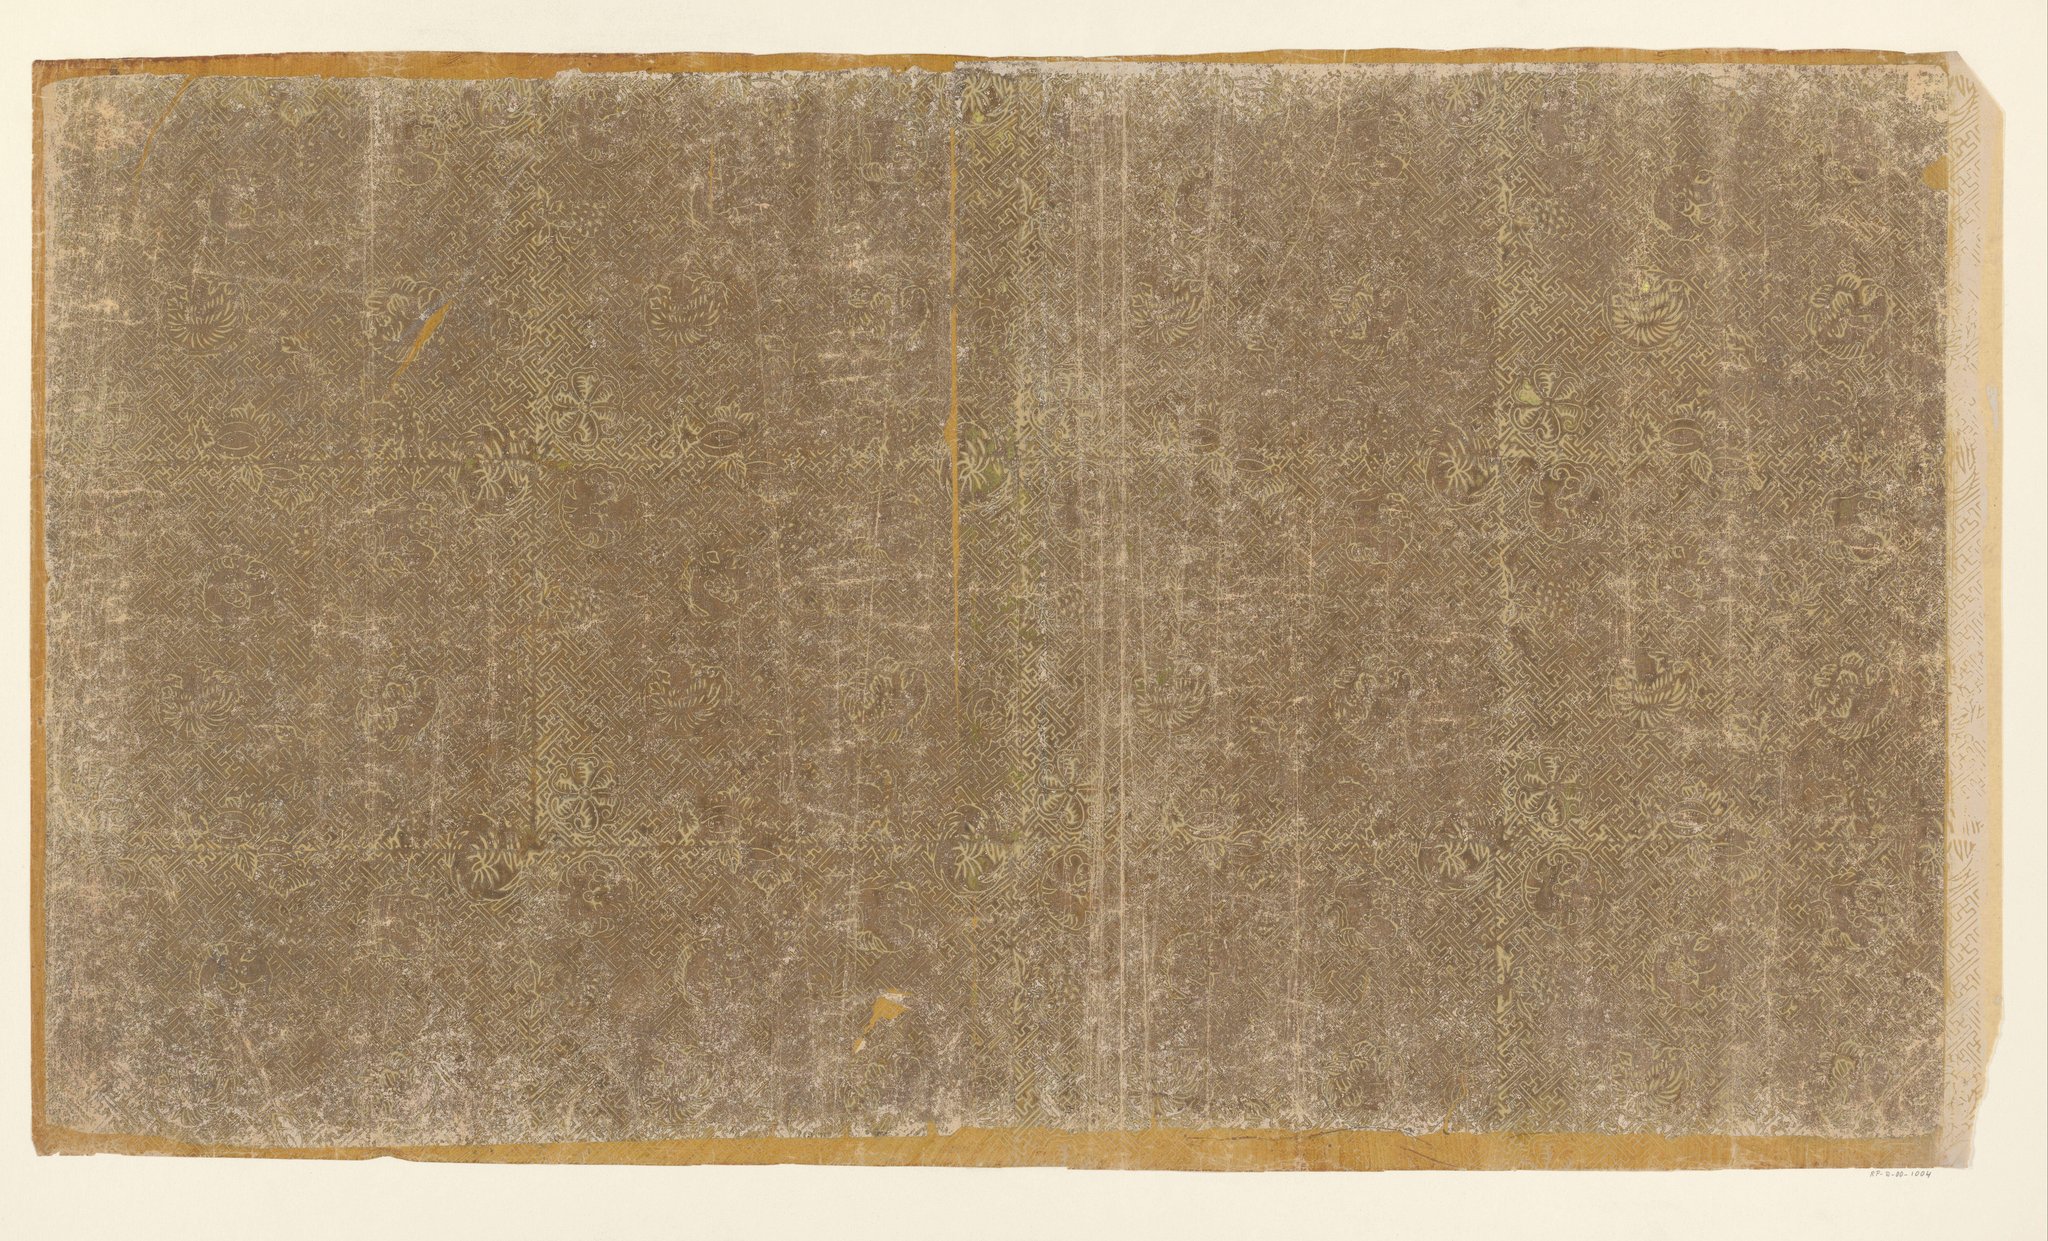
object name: decorated paper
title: Blad met bloemenmotieven over geometrisch meanderpatroon (één van drie identieke bladen)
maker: Anonymous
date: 1850-1950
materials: paper, gold leaf, paint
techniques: printing block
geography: japan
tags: ornament ~ meander, ornament derived from plant forms